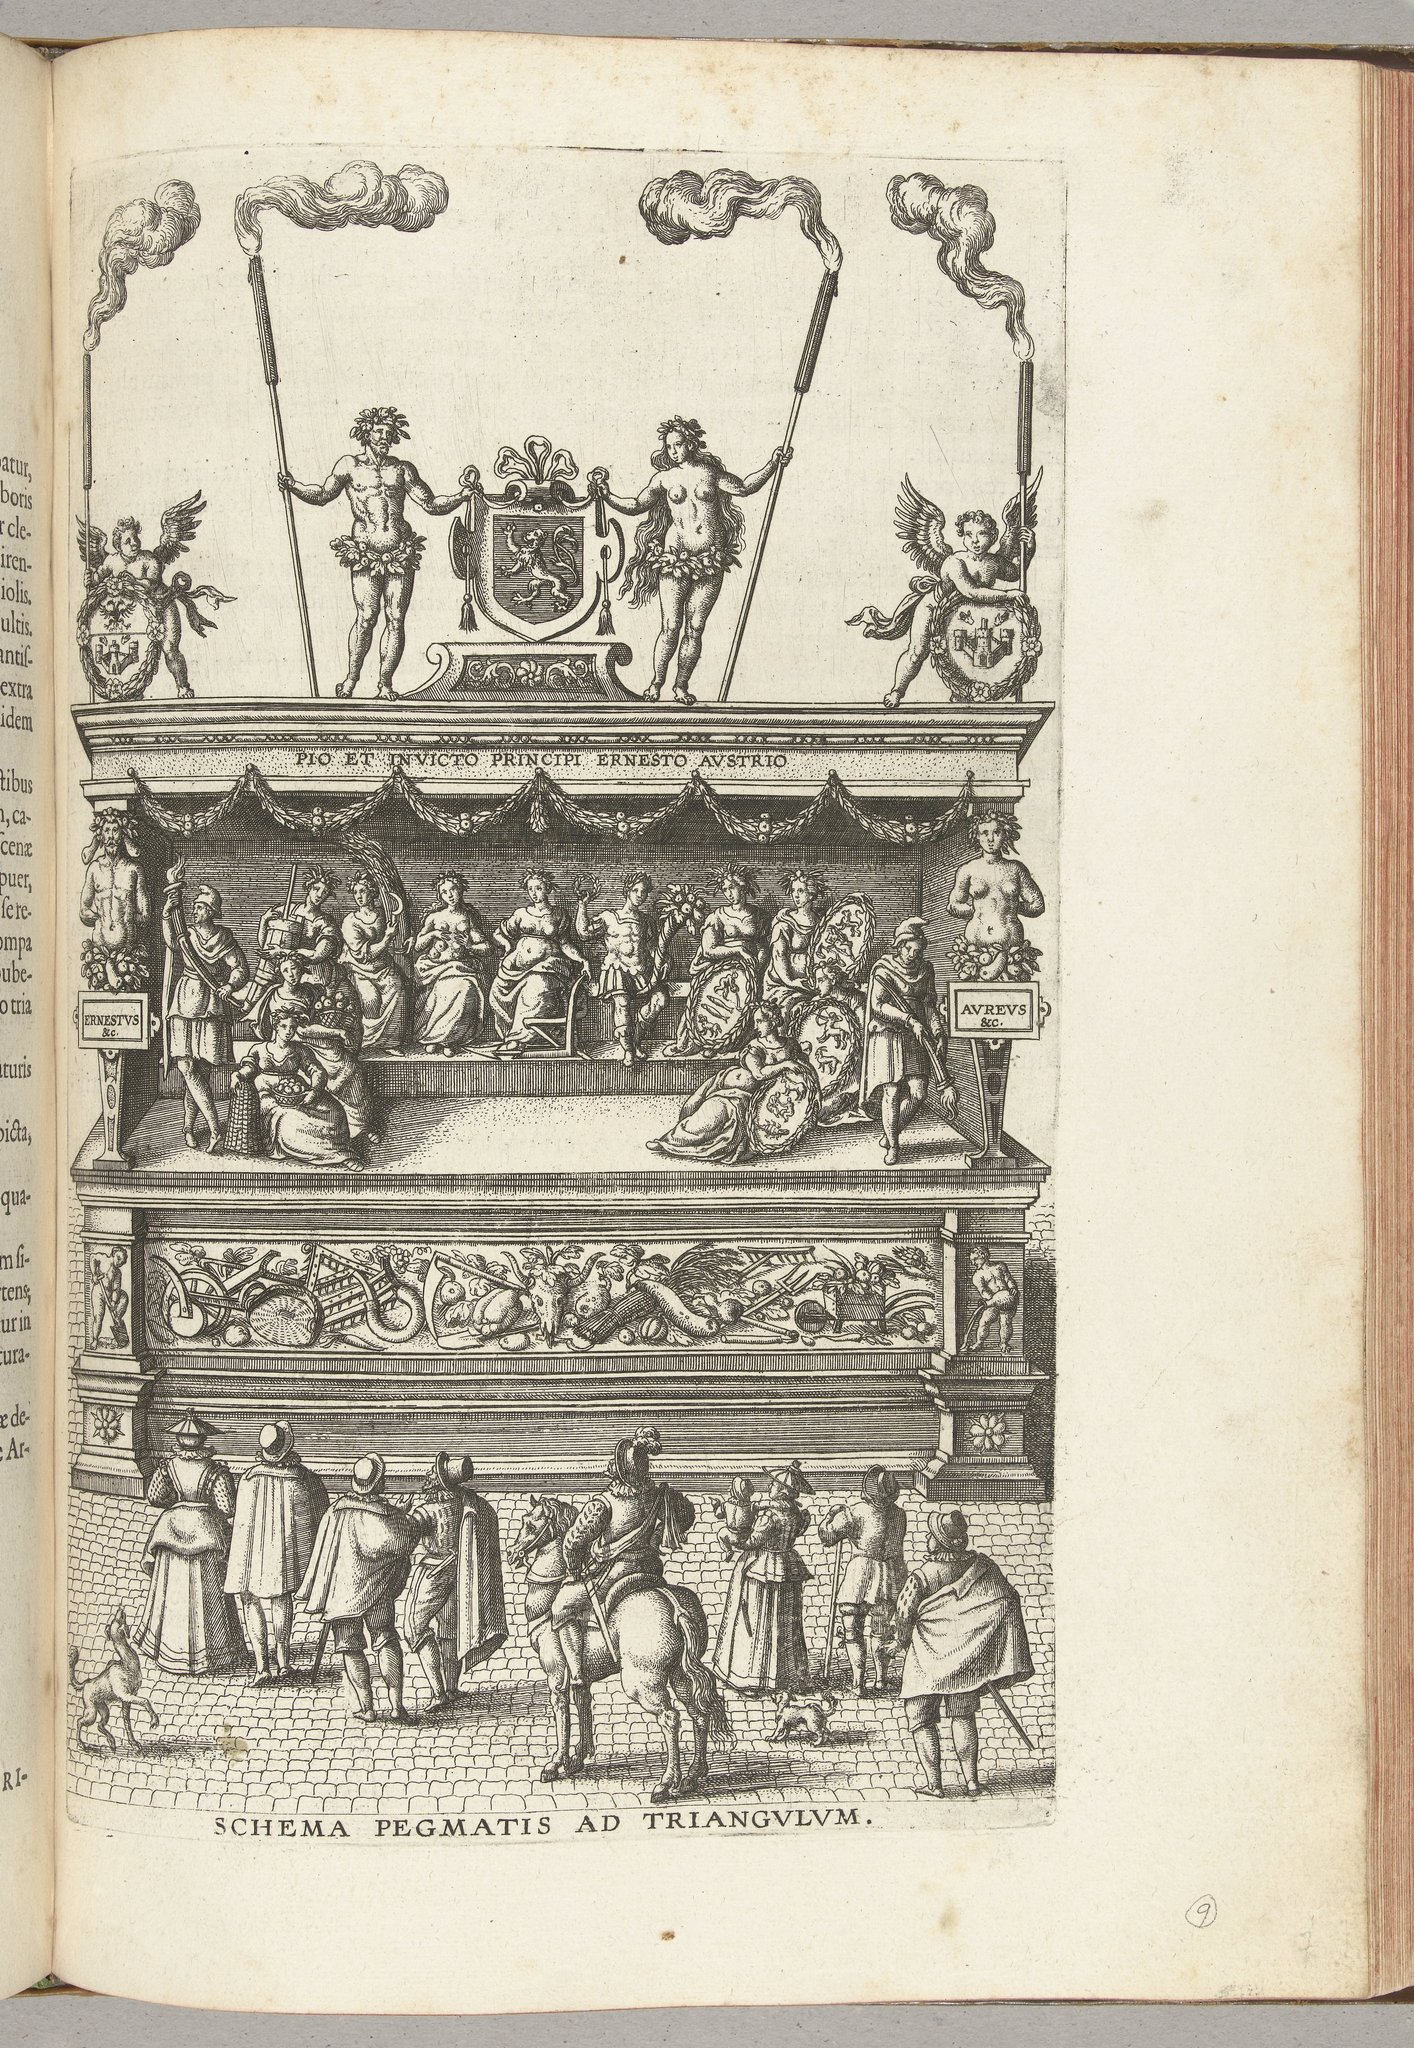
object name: print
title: Schema Pegmatis ad Triangulam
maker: pieter van der borcht (i)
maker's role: print maker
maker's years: 1545-1608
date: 1594-1595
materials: paper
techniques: etching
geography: antwerp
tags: vienna, brussels, triumphal entry and public reception, pageant, 'entrée solennelle', 'joyeuse entrée', personification of agriculture, 'agricultura'; 'agricoltura', 'studio dell'agricoltura' (ripa), antwerp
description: Toneel ter ere van de Landbouw. Opgericht in de Driehoek. Onderdeel van de beschrijving van de intocht van aartshertog Ernst te Antwerpen, 18 juli 1594, door Joannes Bochius, Descriptio publicae gratulationis, spectaculorum et ludorum, in adventu Sereniss. Principis Ernesti Archiducis Austriae, Ex Officina Plantiniana, Antwerpen 1595.